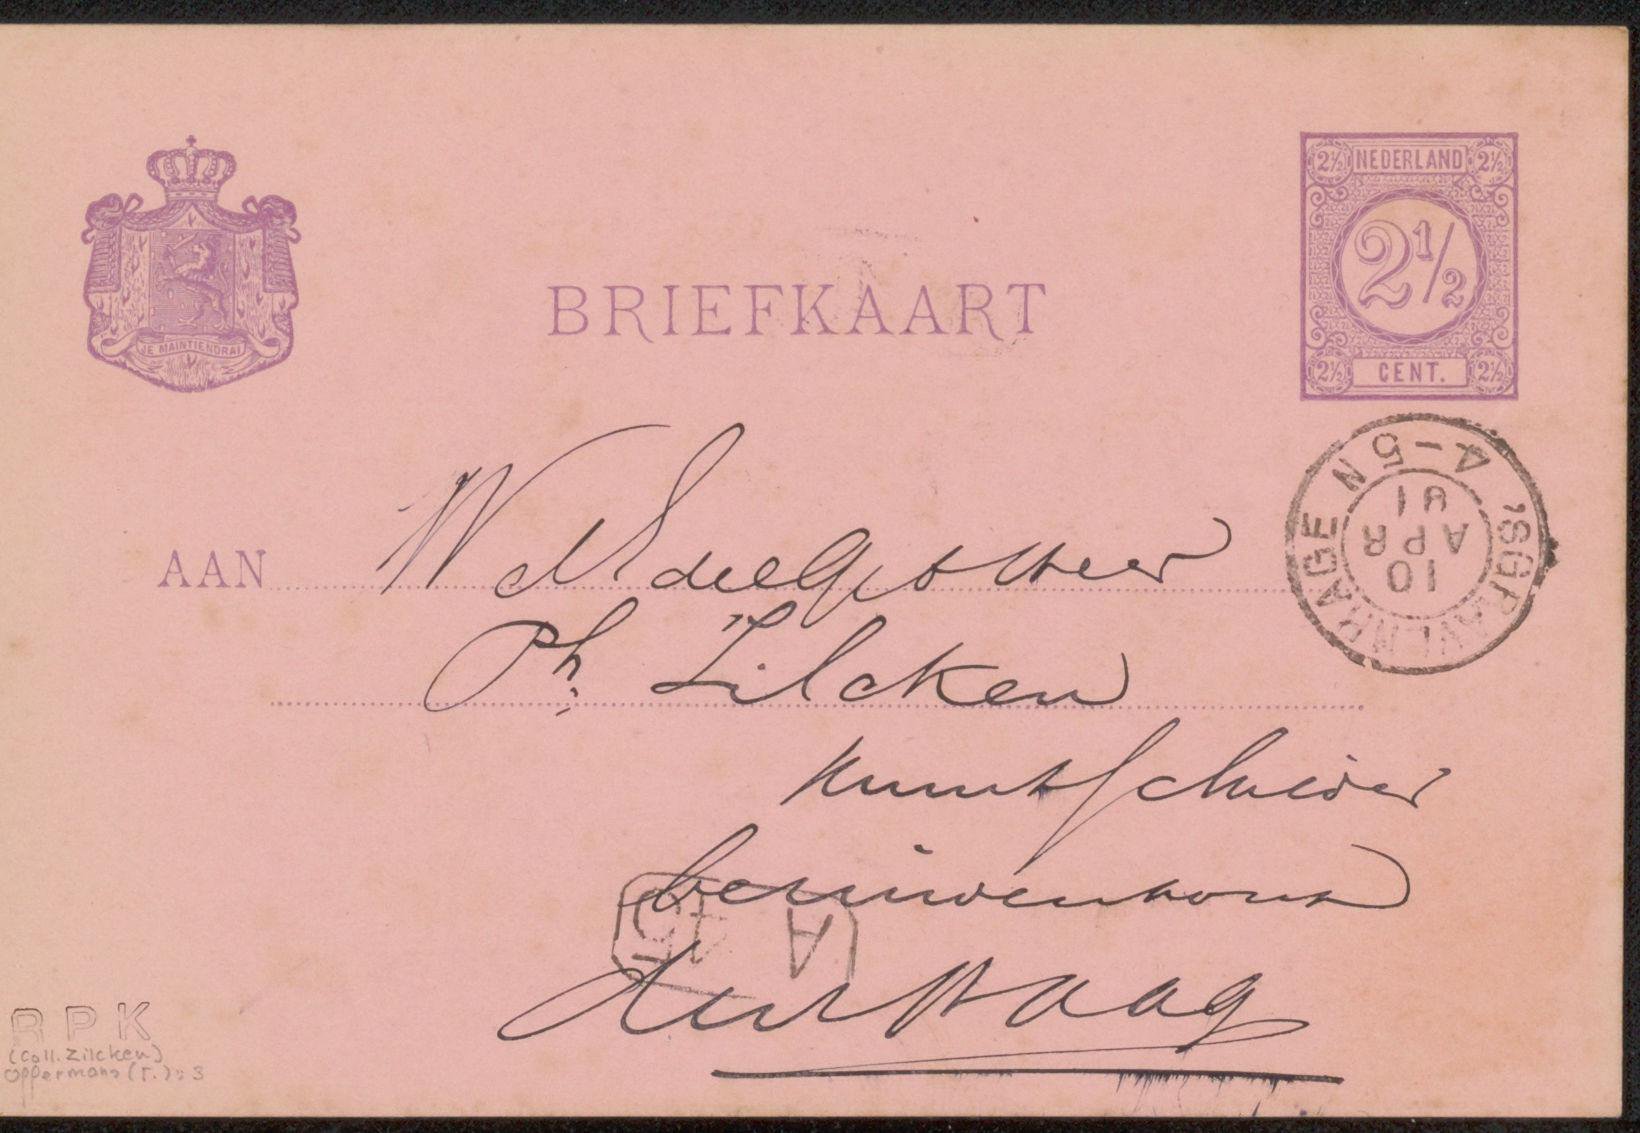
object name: postcard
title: Briefkaart aan Philip Zilcken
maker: tony lodewijk george offermans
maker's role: genreschilder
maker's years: 1854-1911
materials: cardboard, ink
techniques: pen, writing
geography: the hague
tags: the hague, painter, draughtsman, philip zilcken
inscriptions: collector's mark: ‘RPK’